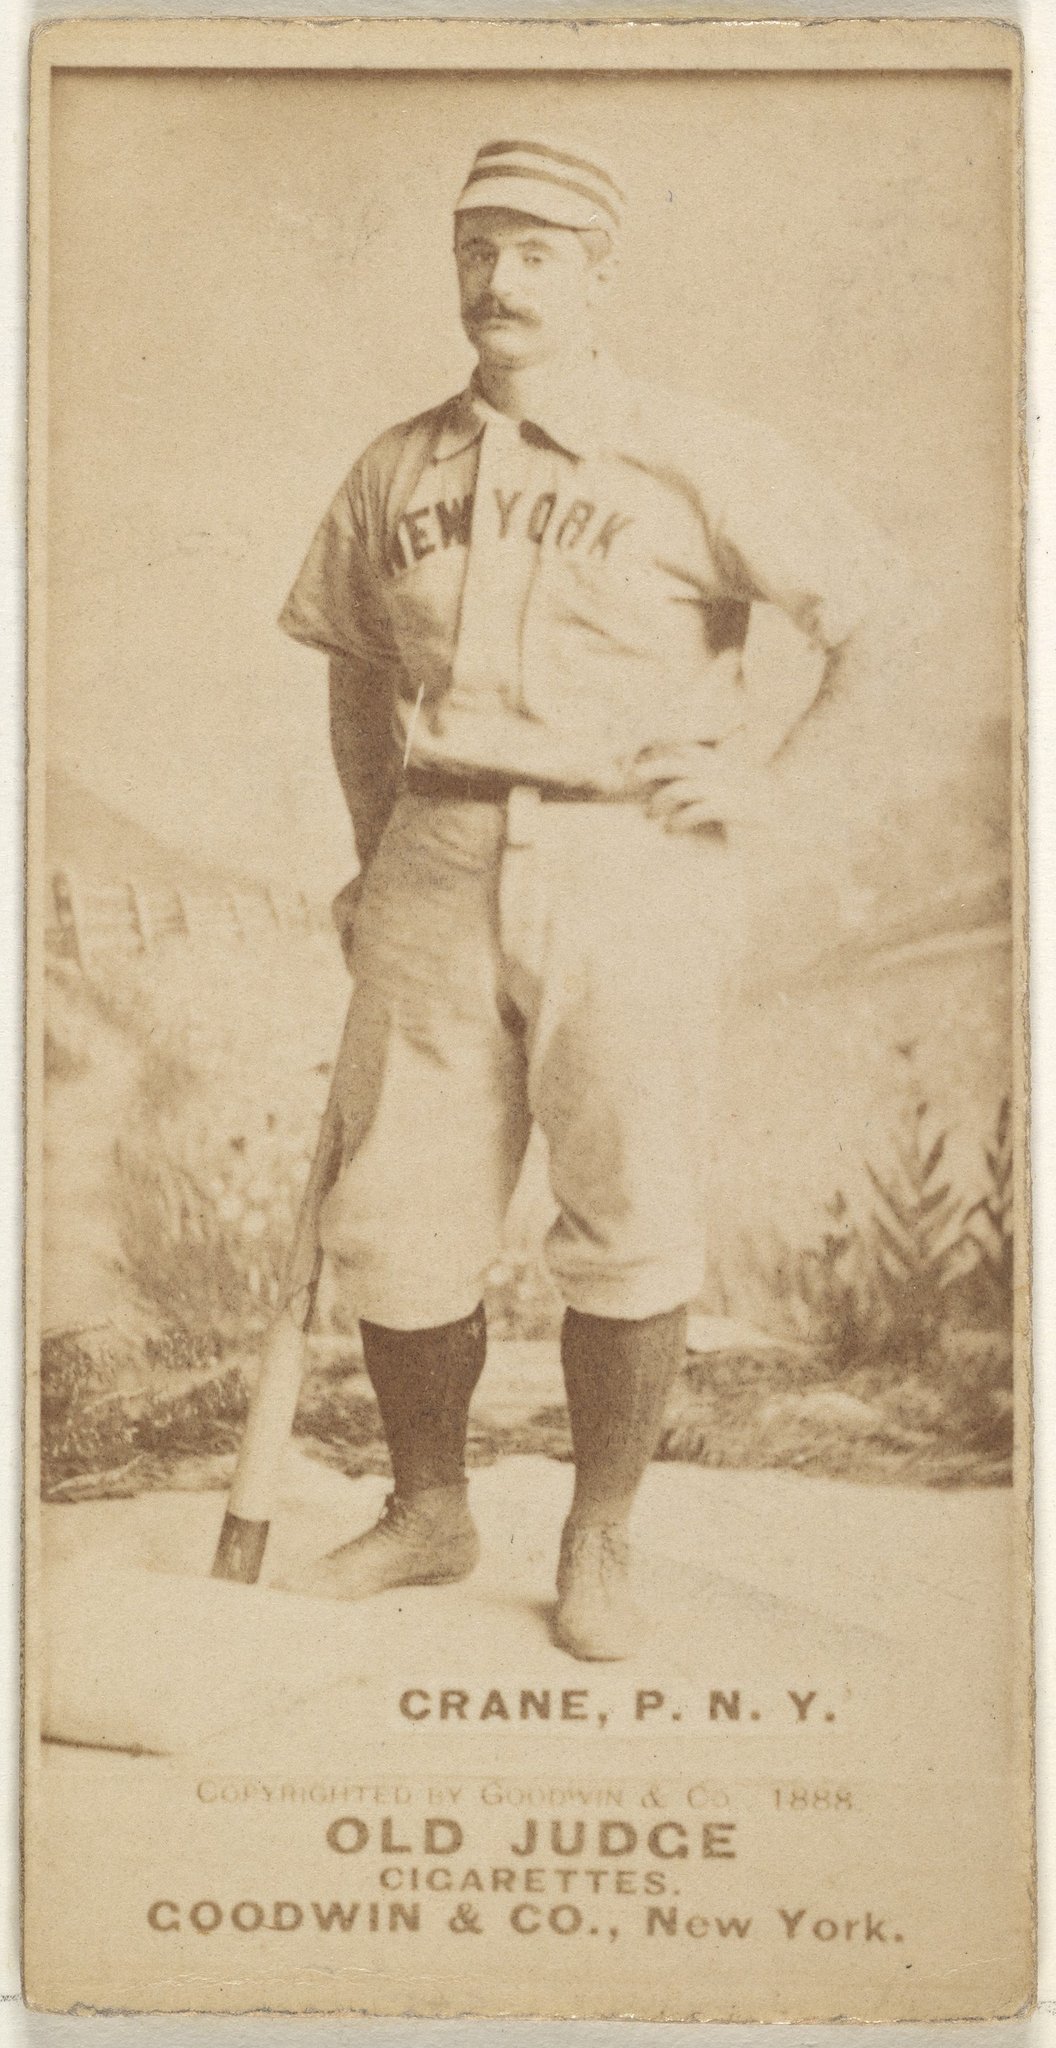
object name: baseball card, photograph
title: Ed Crane, Pitcher, New York, from the Old Judge series (N172) for Old Judge Cigarettes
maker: goodwin & company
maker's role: publisher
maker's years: 1850-1950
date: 1888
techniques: albumen silver print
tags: men,portraits,baseball,athletes